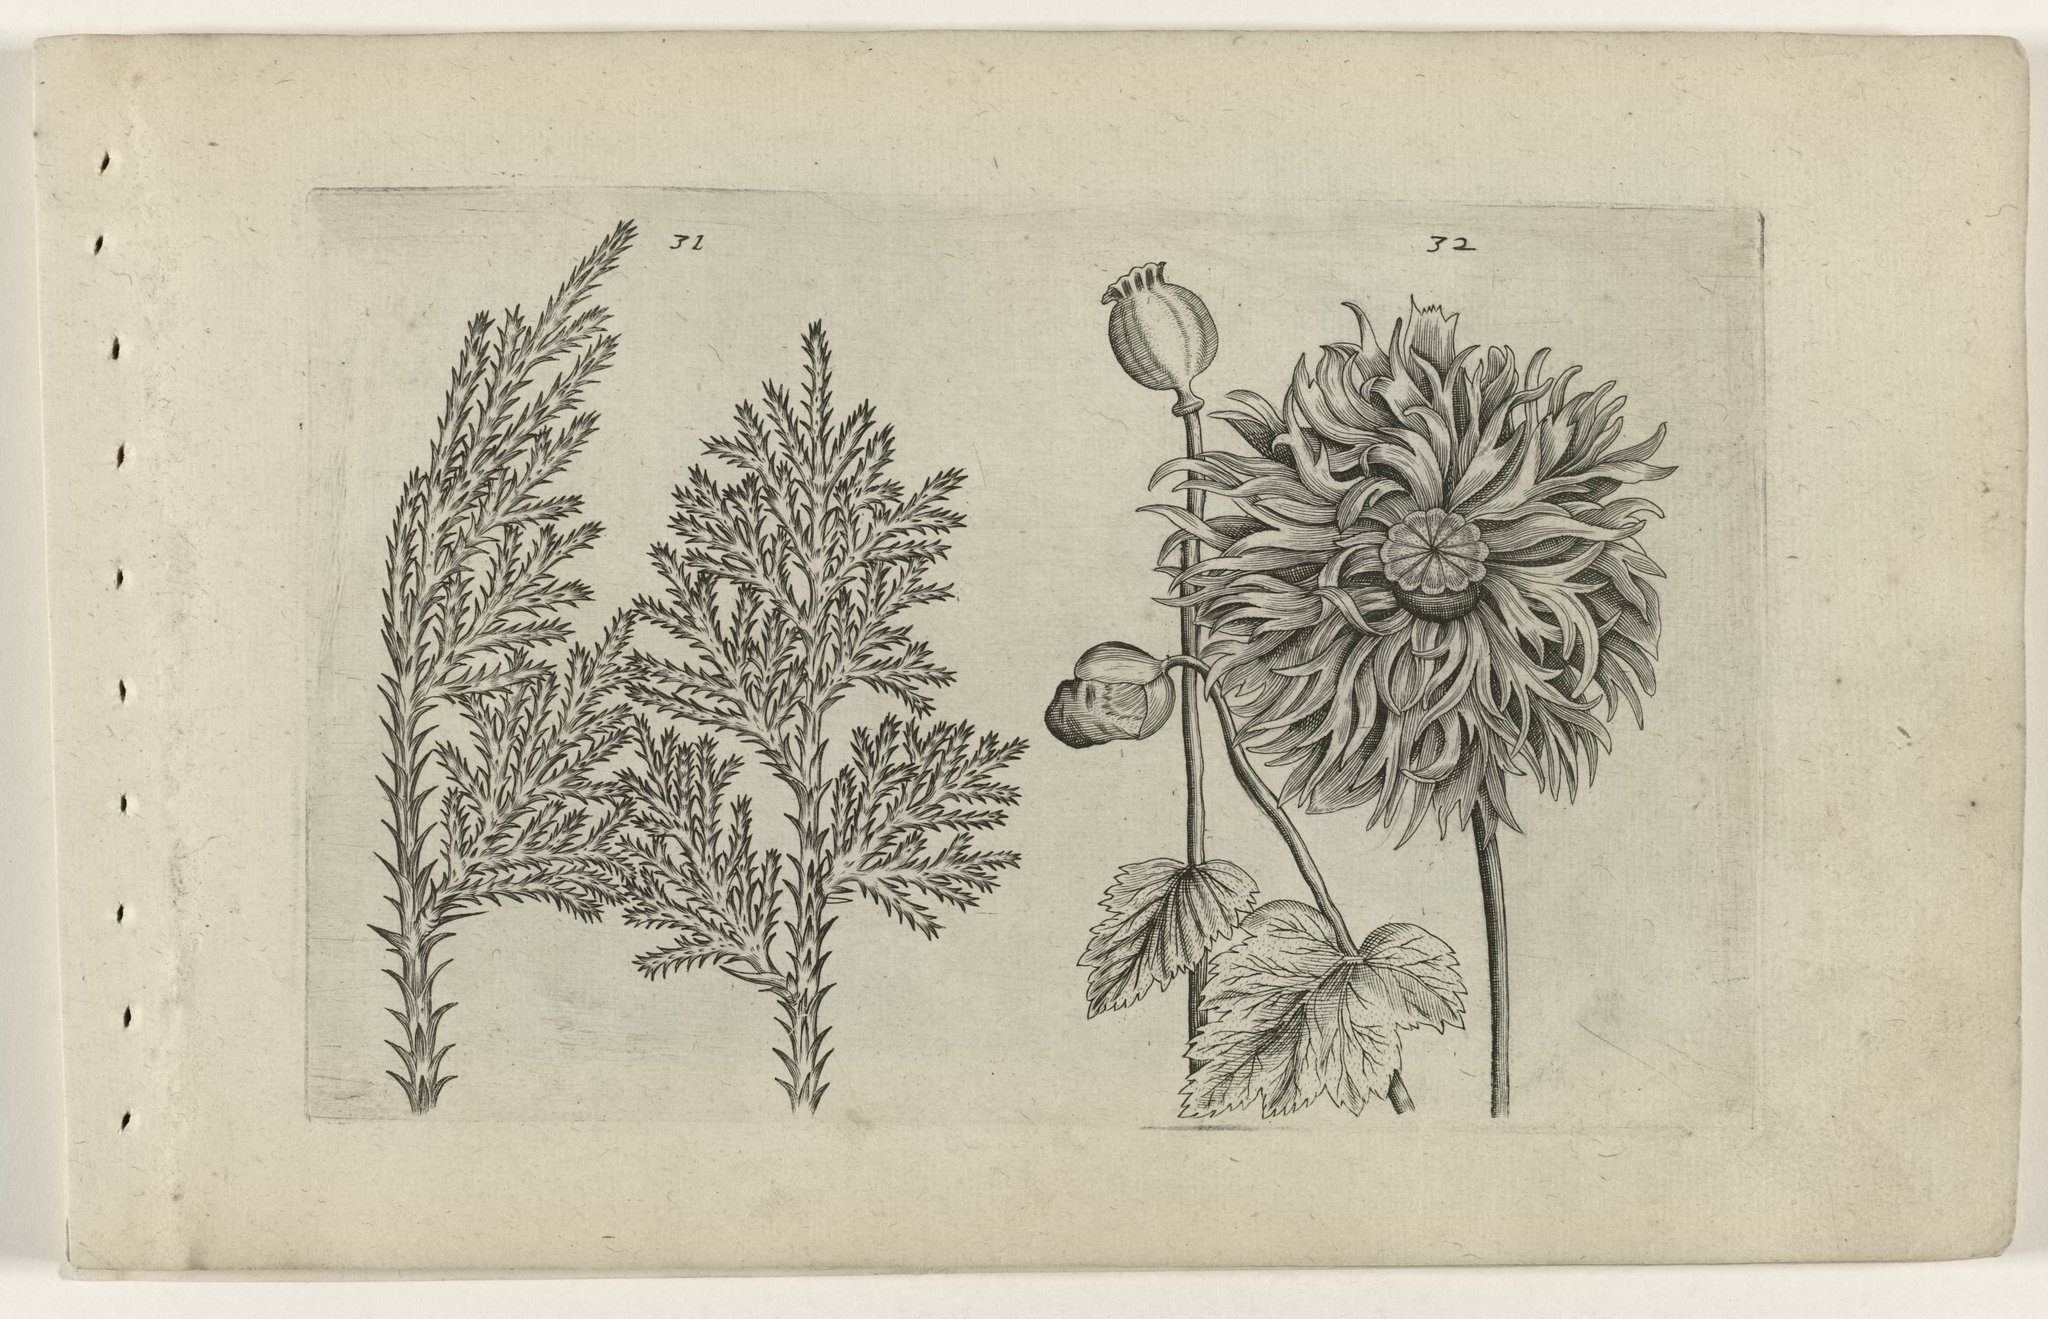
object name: album leaf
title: Cognoscite lilia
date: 1600-1604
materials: paper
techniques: engraving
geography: cologne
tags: botany, flowers: poppy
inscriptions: collector's mark: Lugt 2228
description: De prenten RP-P-2012-24-1 t/m 61 waren oorspronkelijk als serie samengebonden. De naaigaten op de bladen zijn nog zichtbaar. Het betreft de reeks getiteld: Cognoscite lilia, bestaande uit een titelprent en 60 gravures met 119 genummerde weergaven van planten, bloemen en vruchten, versierd met rinceaux en kleine voorstellingen van dieren. Het gaat om proefdrukken van deze reeks gravures, voor de opschriften en, deels, voor de nummering. Op enkele prenten zijn de nummers met de hand aangebracht. Op de titelprent ontbreekt nog het adres van Crispijn de Passe en Hans Woutneel. De titel is hoogstwaarschijnlijk gegraveerd door Matthias Quad. Deze werkte voor De Passe in Keulen tot 1604. De reeks moet in dit jaar of daarvoor tot stand zijn gebracht. In ieder geval voor 1608, aangezien de uitgever Hans Woutneel in of voor dat jaar overleed. In ieder geval voor 1608, aangezien de uitgever Hans Woutneel in of voor dat jaar overleed. De gravures worden door Ilja Veldman en Anthony Griffiths beschouwd als eigenhandig werk van Crispijn de Passe I. Een van de prenten uit de reeks ontbreekt (nr 21-22) en is vervangen door een ingekleurde afdruk uit een latere uitgave (RP-P-2012-24-61), die onder de titel Altera Pars is opgenomen in de Hortus Floridus, uitgegeven door Crispijn de Passe I en die verder bestaat uit platen van Crispijn de Passe II. De prenten afkomstig uit deze uitgave zijn op de verso voorzien van tekst in boekdruk. De vervangende prent maakte geen deel uit van de gebonden serie aangezien dit blad als enige geen naaigaten heeft. Een deel van de planten, bloemen en vruchten in de Cognoscite lilia gaat terug of is gebaseerd op een reeks aquarellen van Jacques LeMoyne uit circa 1580 en uit 1585, nu in het Victoria and Albert Museum en de British Museum (zie P. Hulton, Jacques LeMoyne, Londen 1977, dl 1, p. 156-162 en p. 165-173).